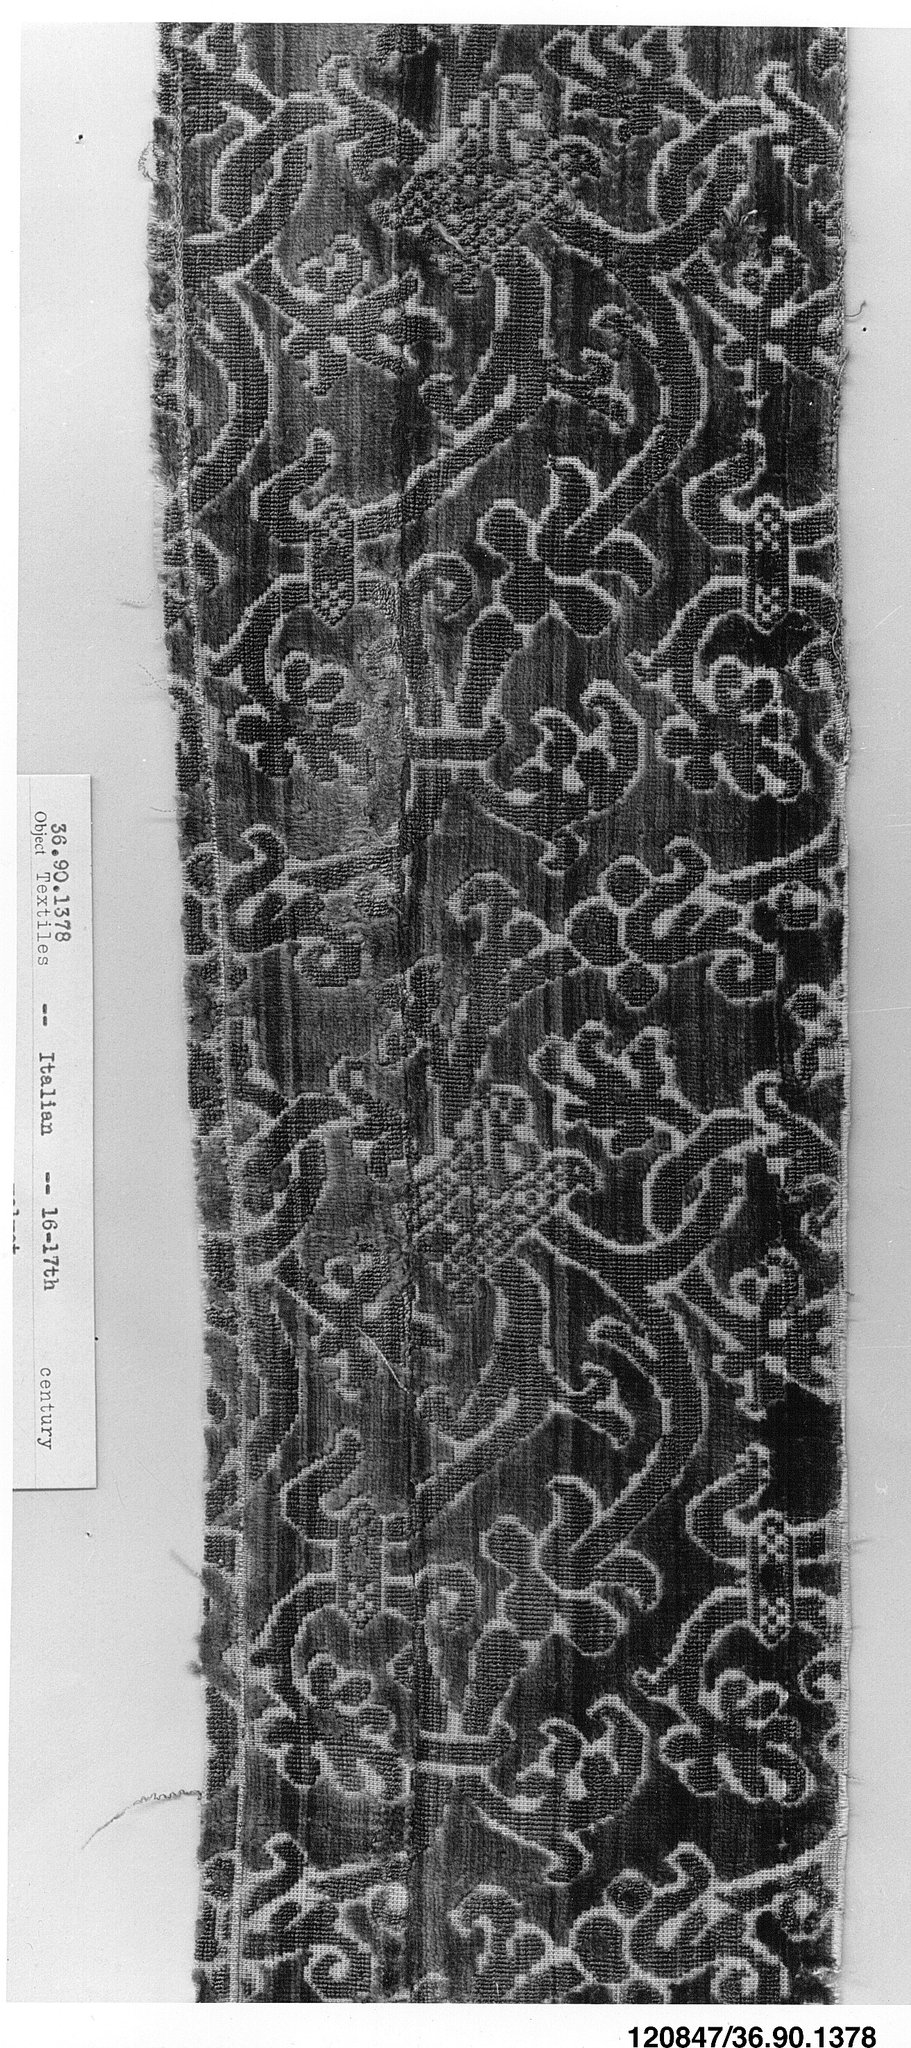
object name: piece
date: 1501-1700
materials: silk